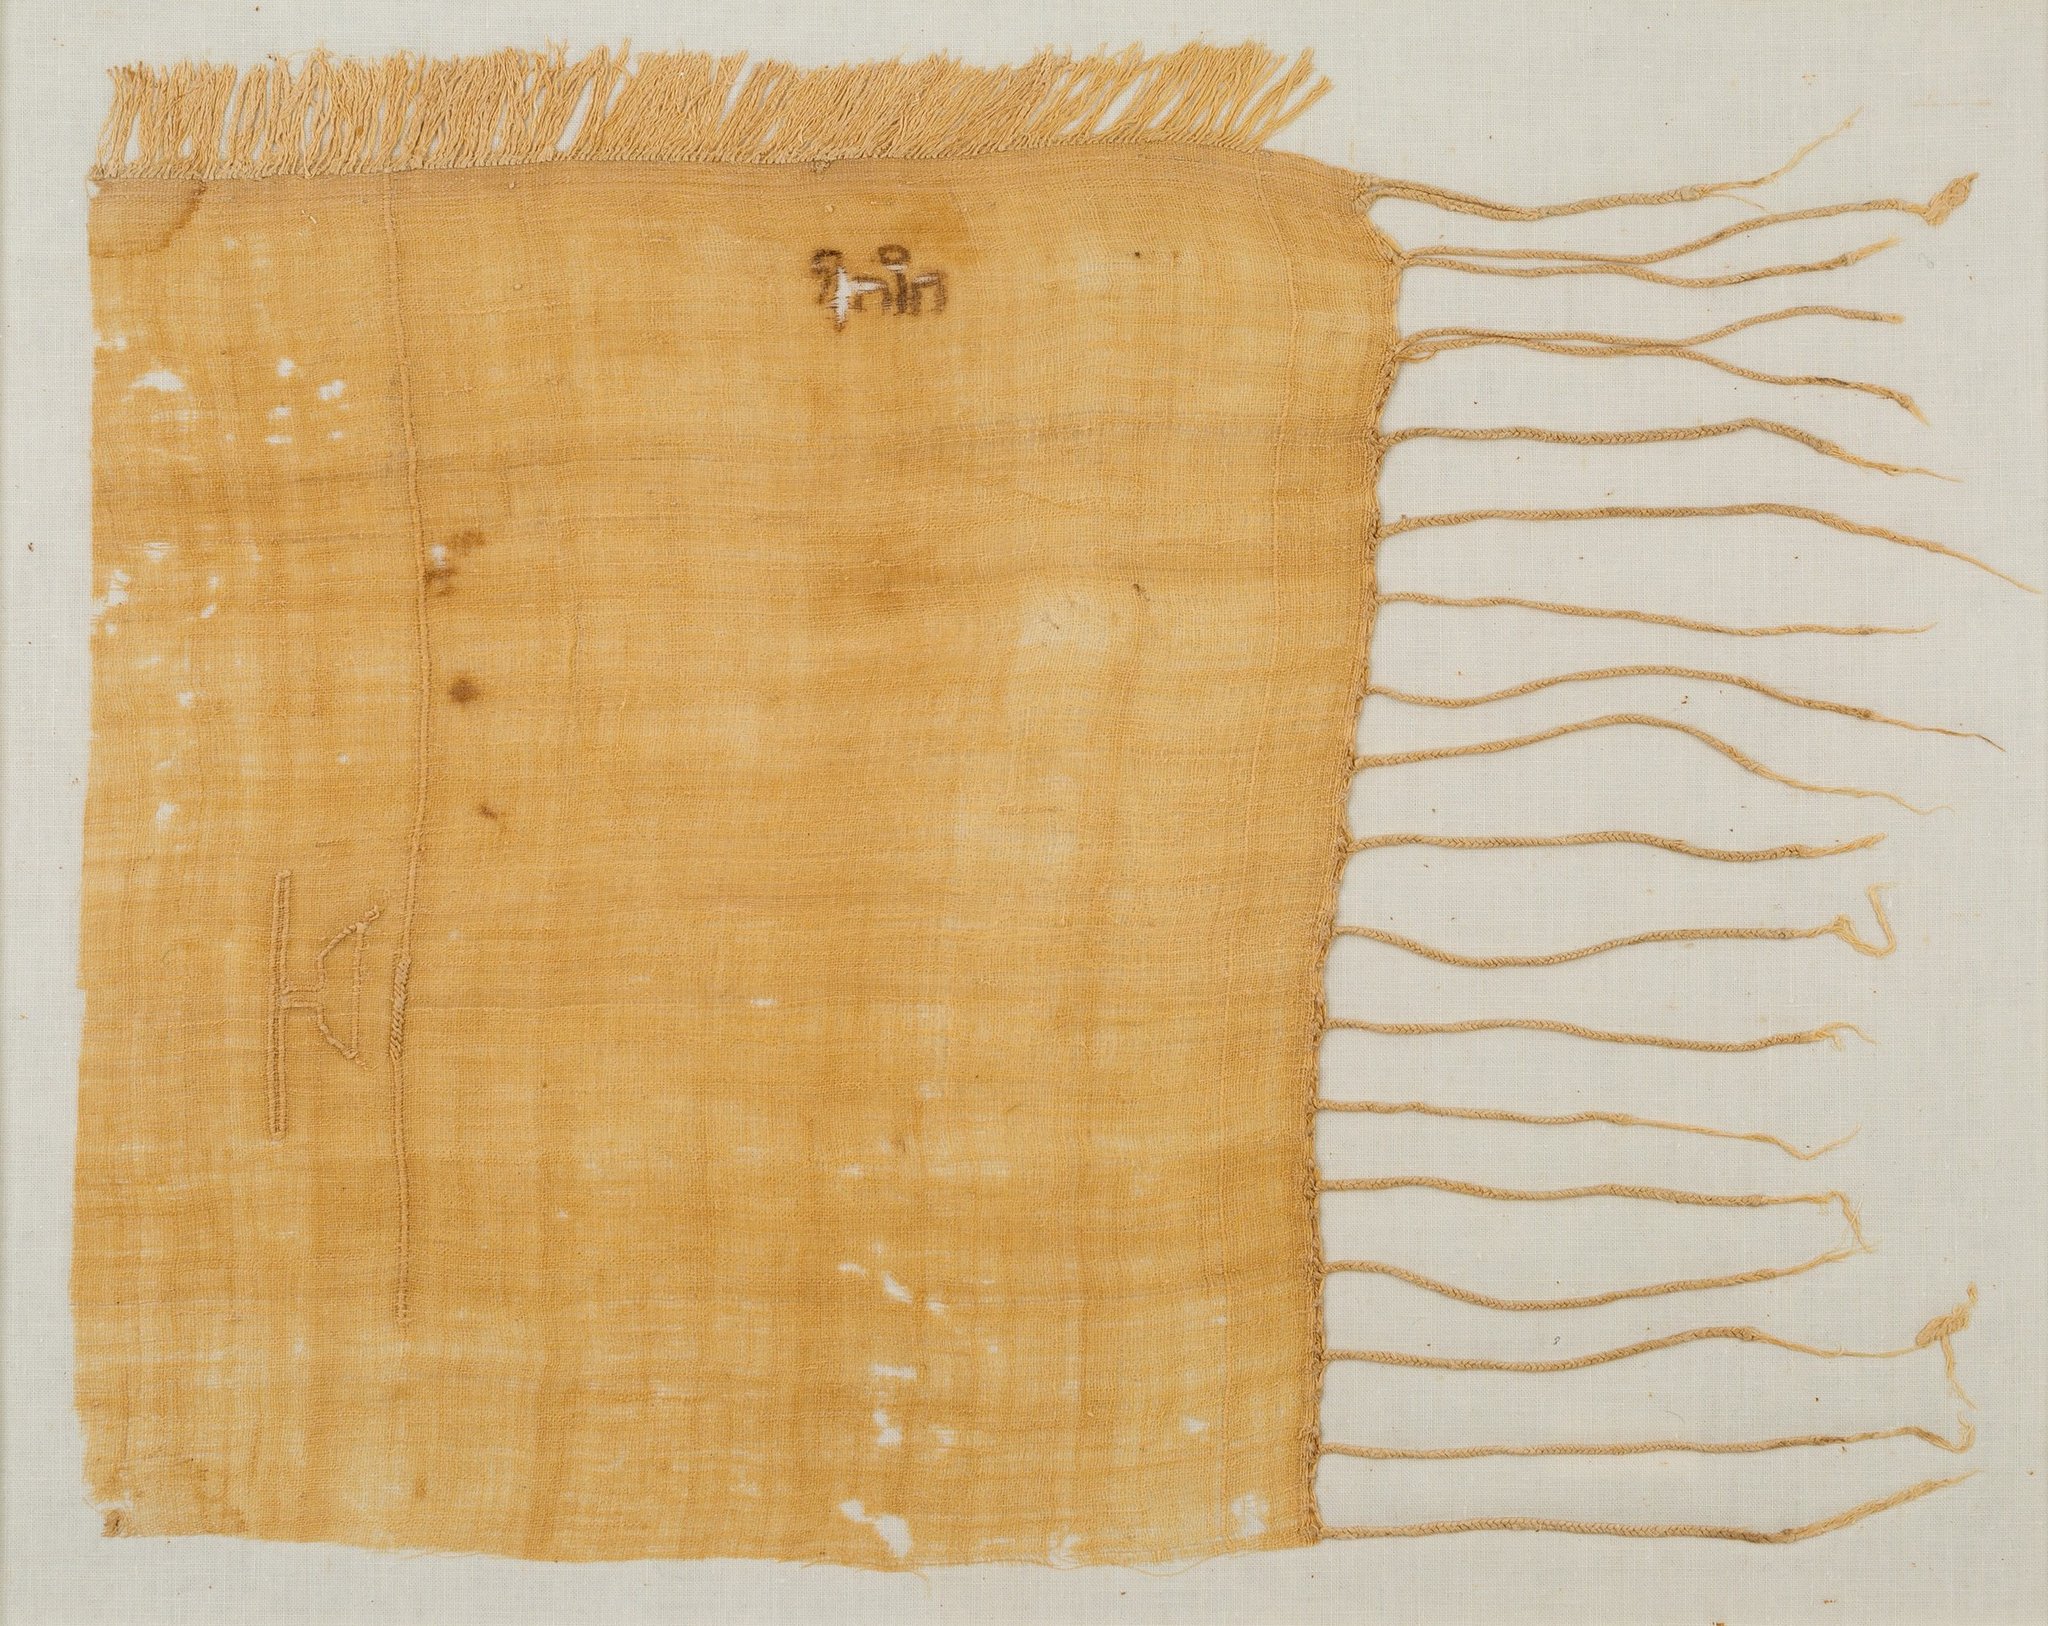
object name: sheet, inscribed, linen mark, pall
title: Corner of a Linen Pall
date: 1492-1473 BCE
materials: ink, linen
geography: egypt